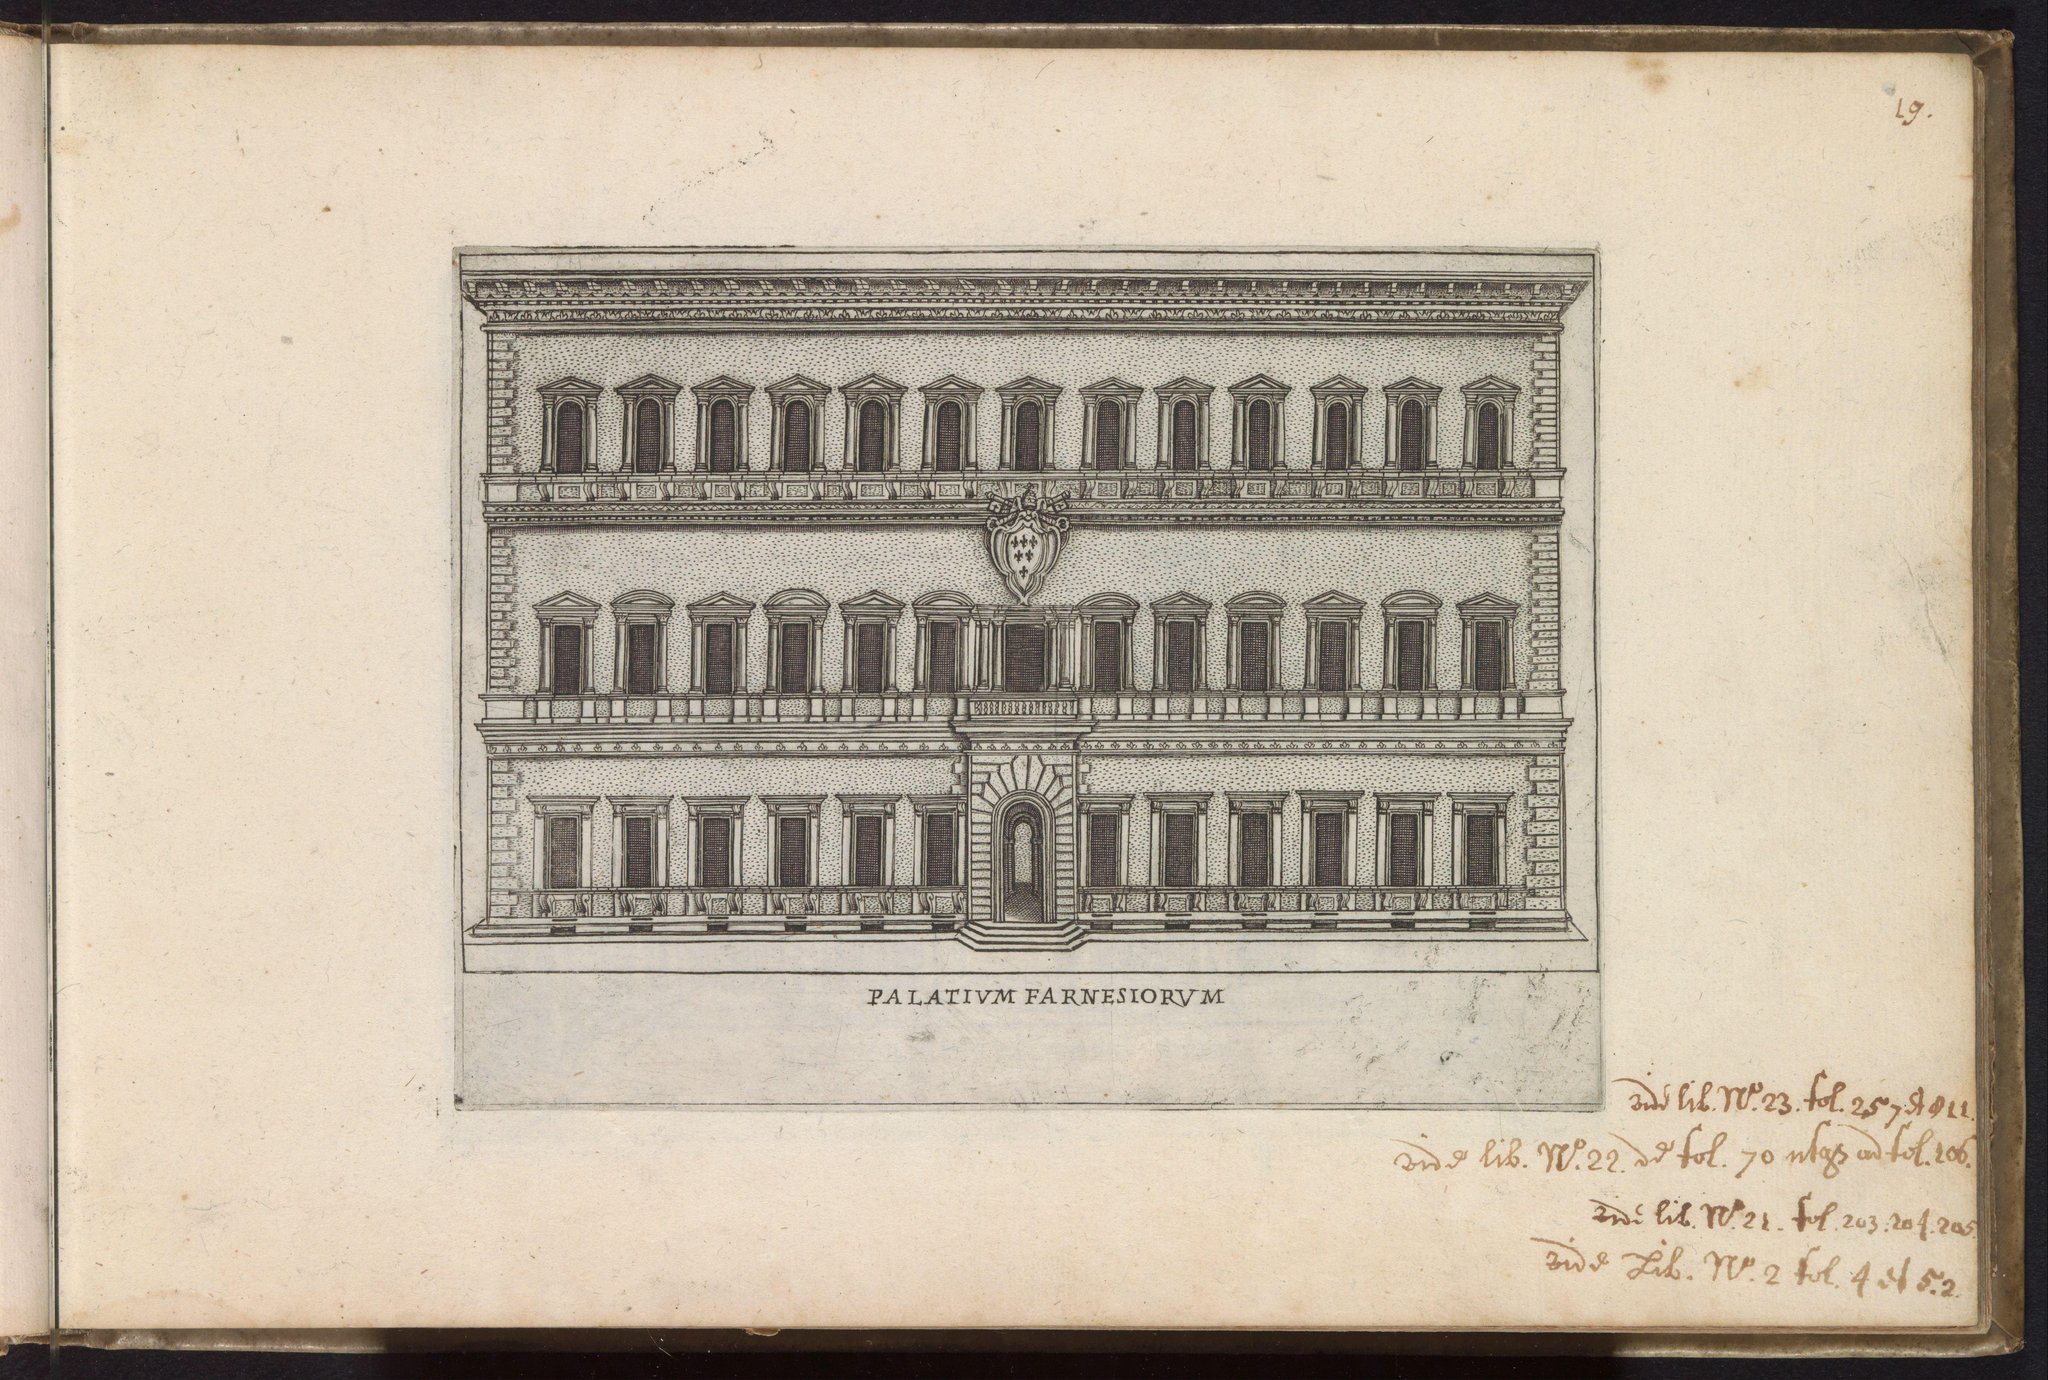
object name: print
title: Beroemde gebouwen in Rome en daarbuiten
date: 1638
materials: paper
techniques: etching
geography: vatican city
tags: hôtel, i.e. small palace in city, façade (of house or building)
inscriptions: number: ‘19’, inscription: ‘Ende lib. no. 23. fol. 257 et 811/ Ende lib. No. 22. [...] fol. 70...’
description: Prent maakt deel uit van een reeks prenten (+ titelprent) van beroemde gebouwen in Rome en elders.